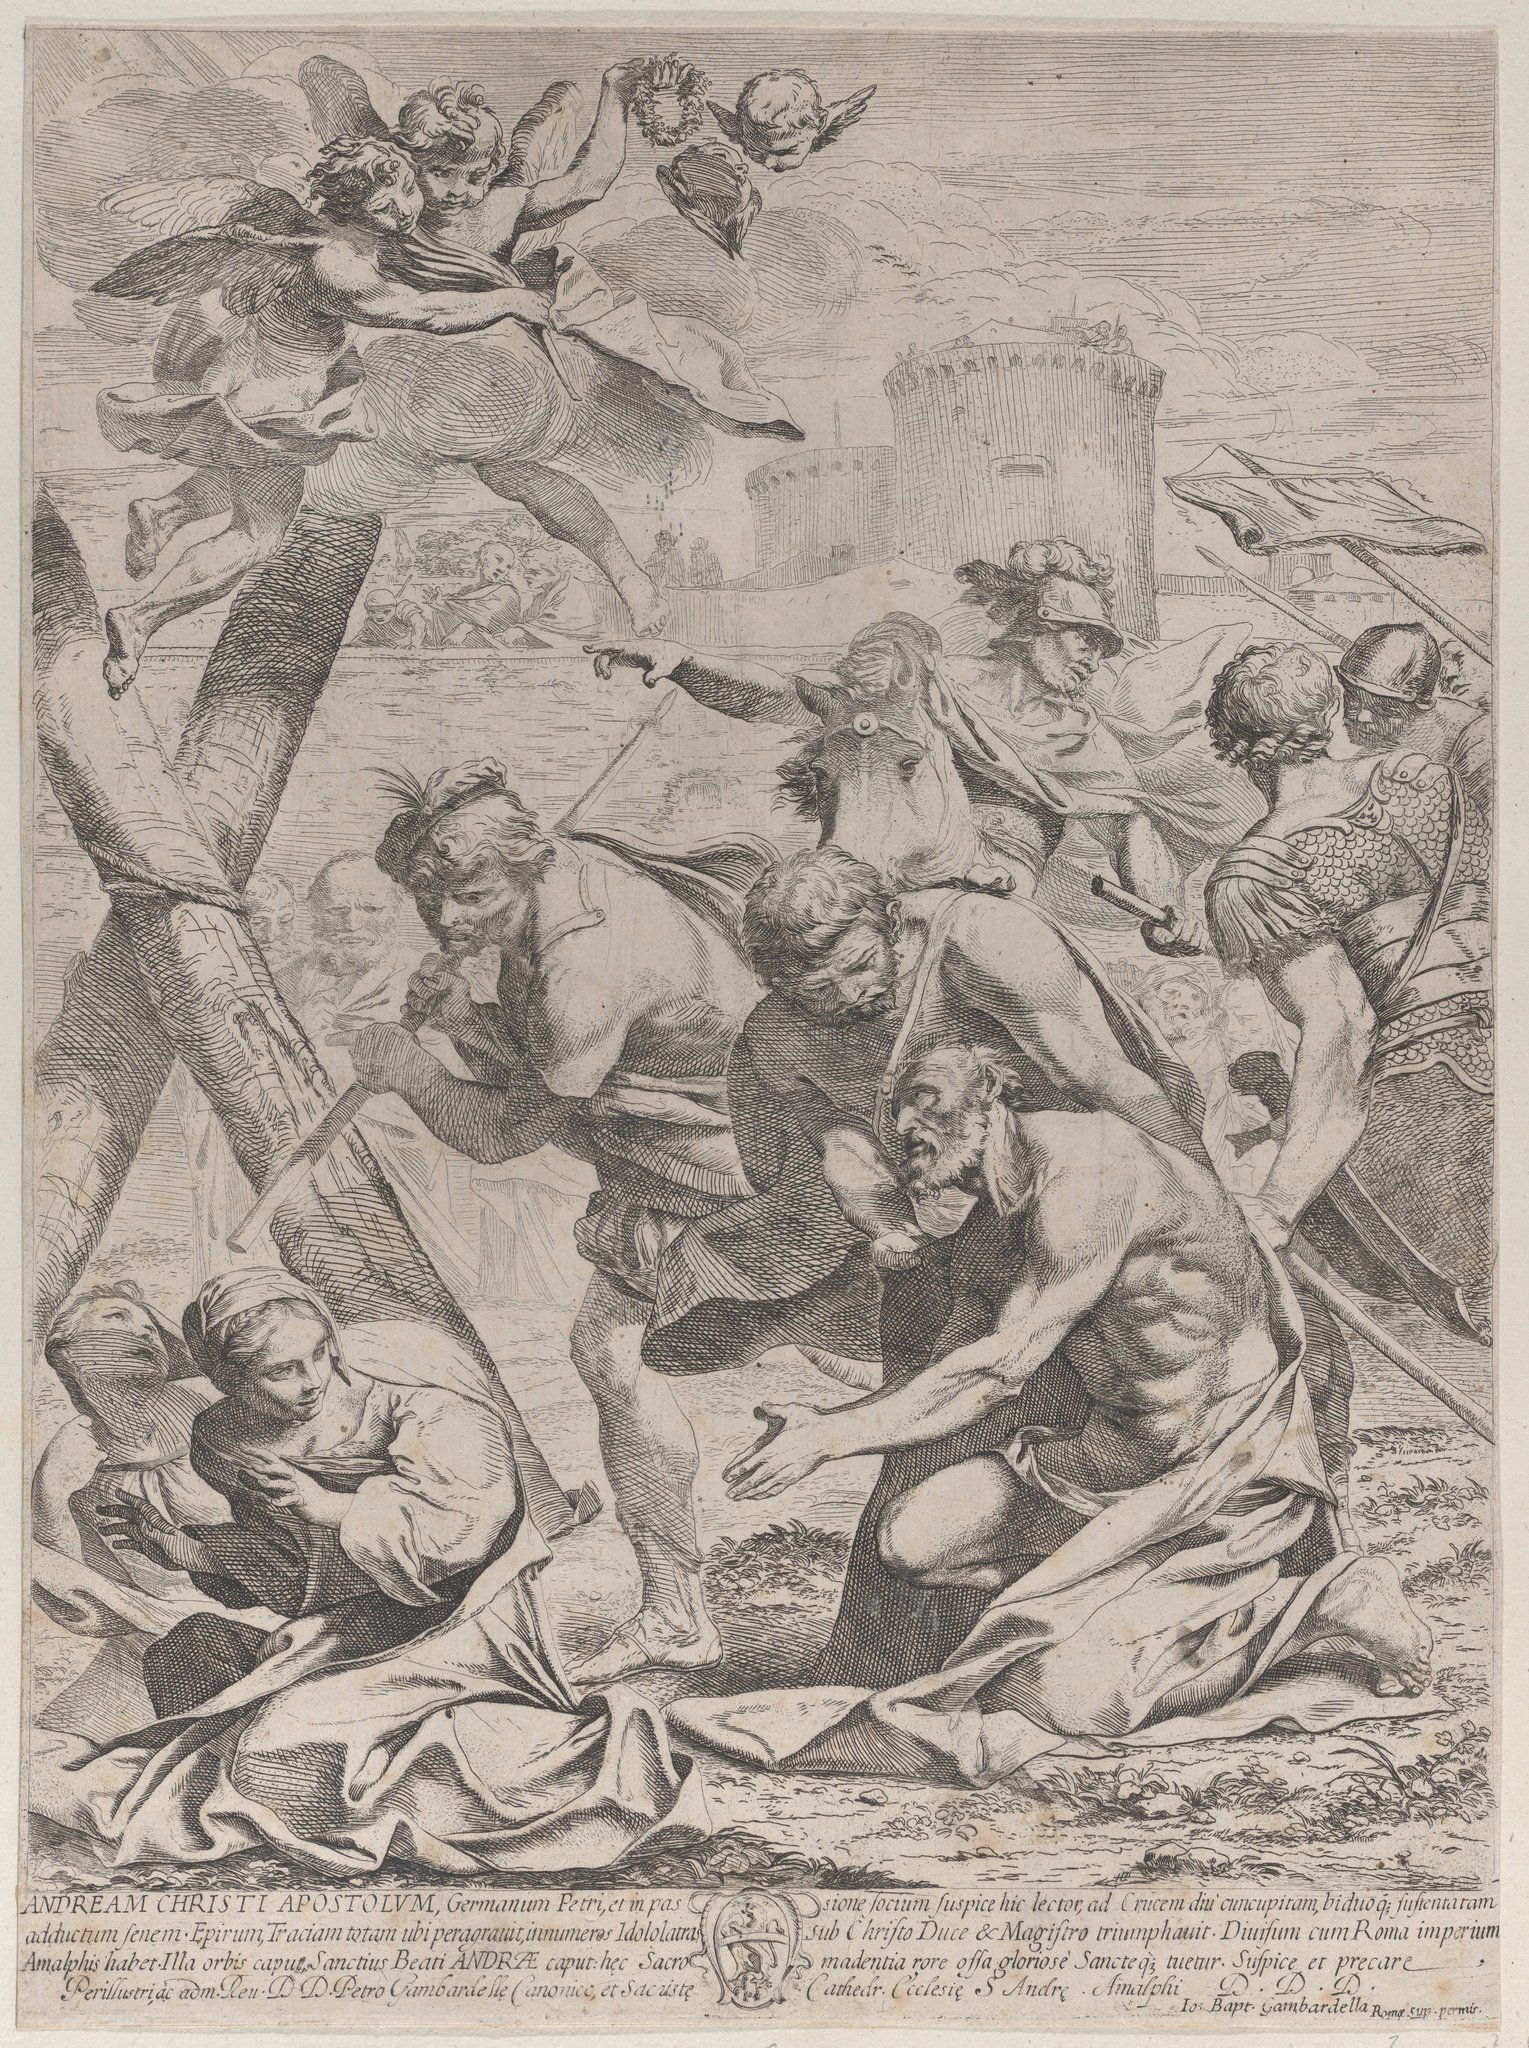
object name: print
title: Saint Andrew praying before a crucifix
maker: francesco giovane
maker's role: artist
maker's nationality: italian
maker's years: 1611-1669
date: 1640-1670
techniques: etching